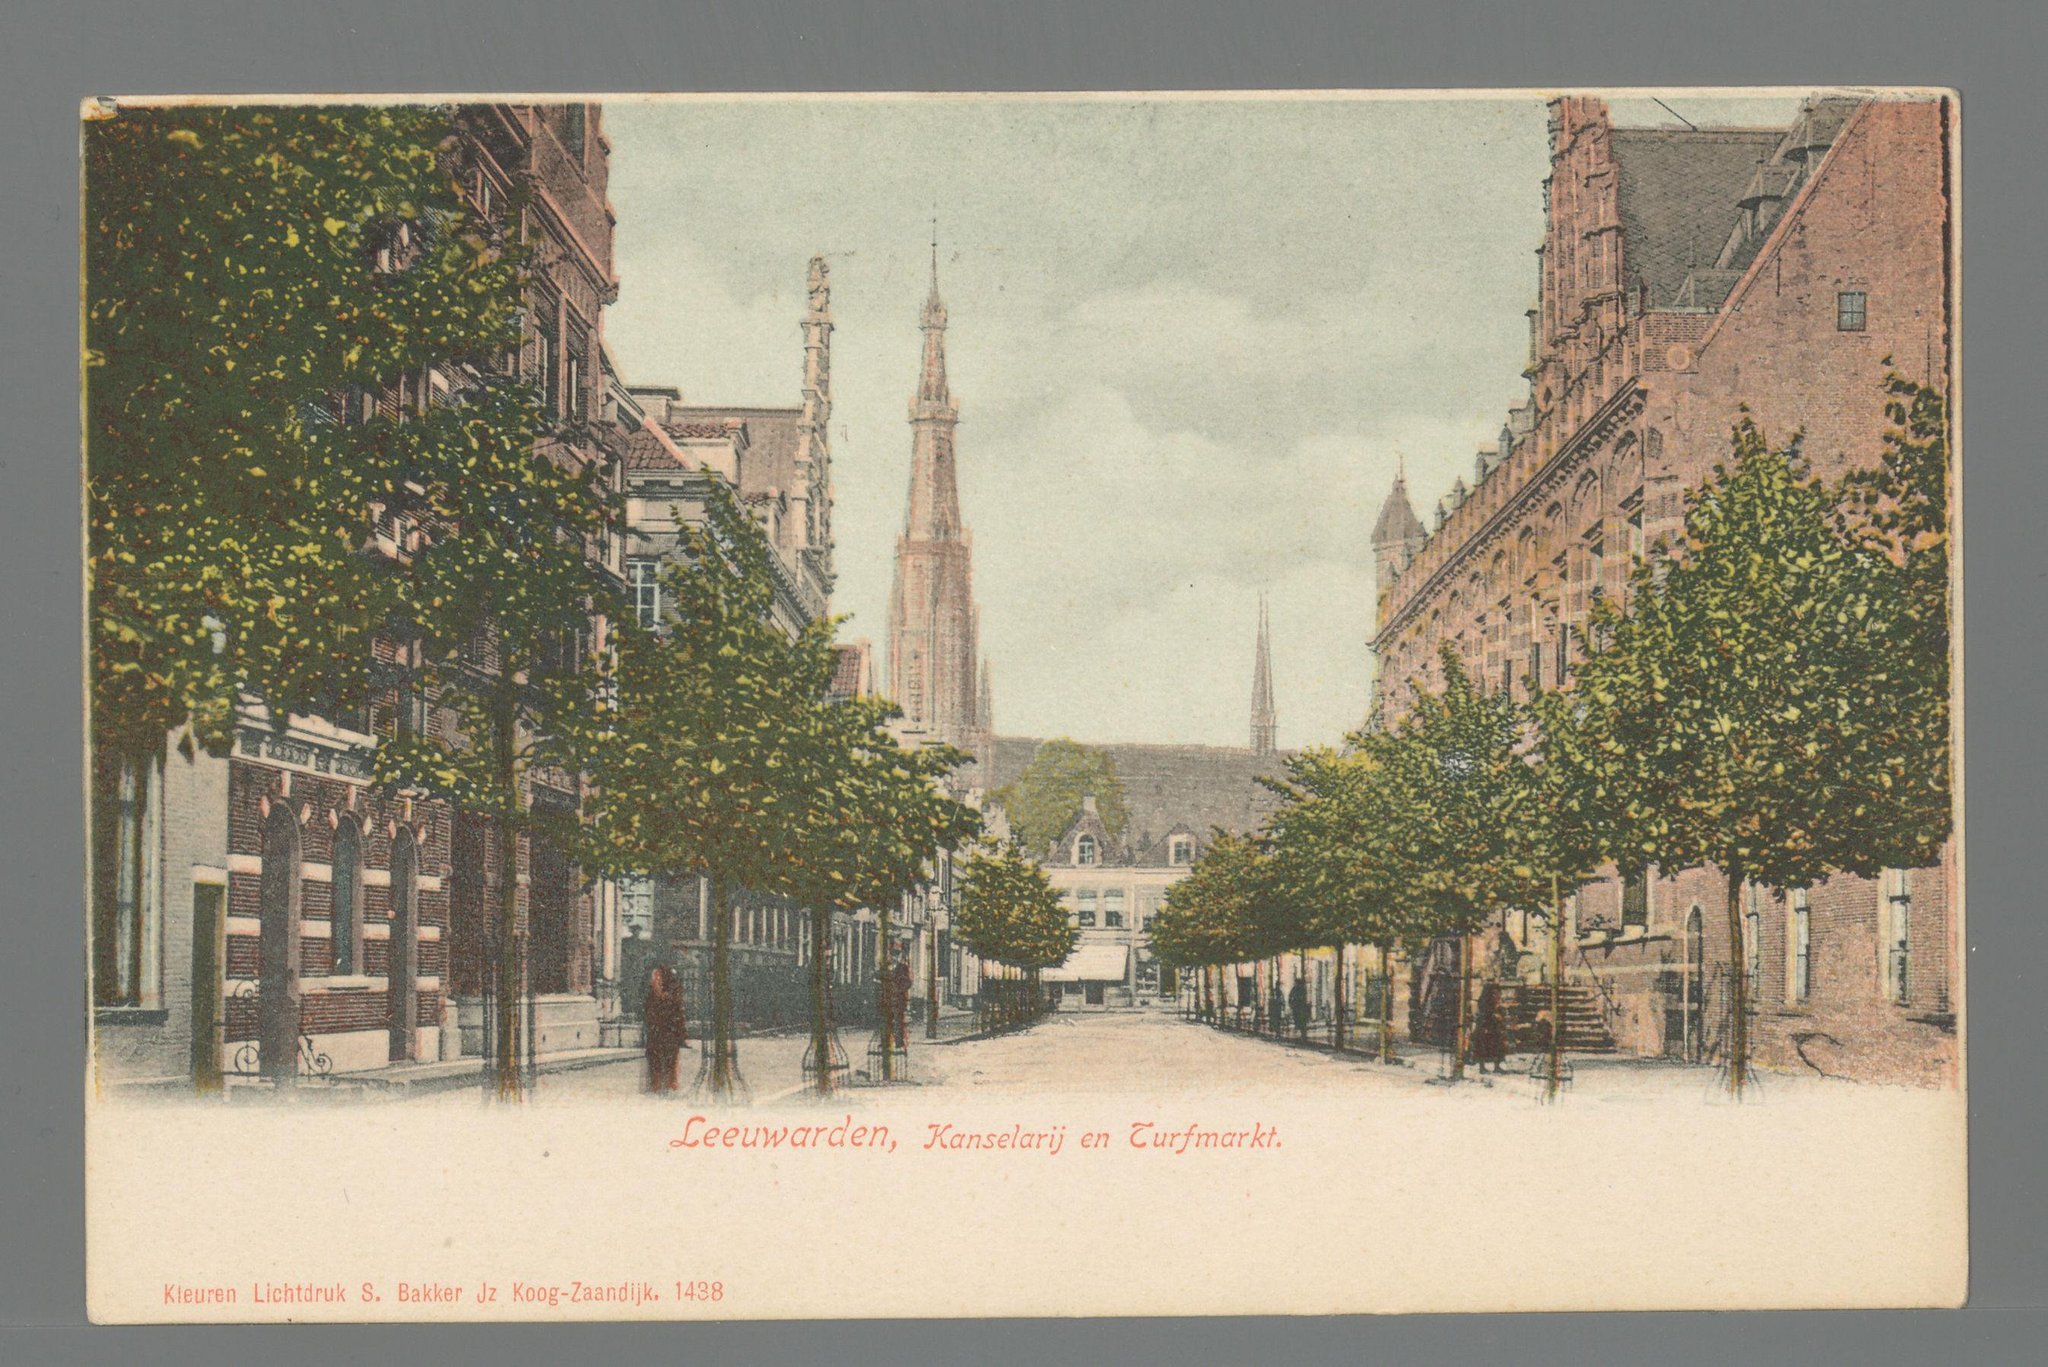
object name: photomechanical print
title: Leeuwarden, Kanselarij en Turfmarkt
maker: simon bakker jz.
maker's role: printer, publisher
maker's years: 1873-1930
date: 1899-1905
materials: cardboard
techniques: photograph, lithograph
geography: koog aan de zaan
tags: church (exterior), street